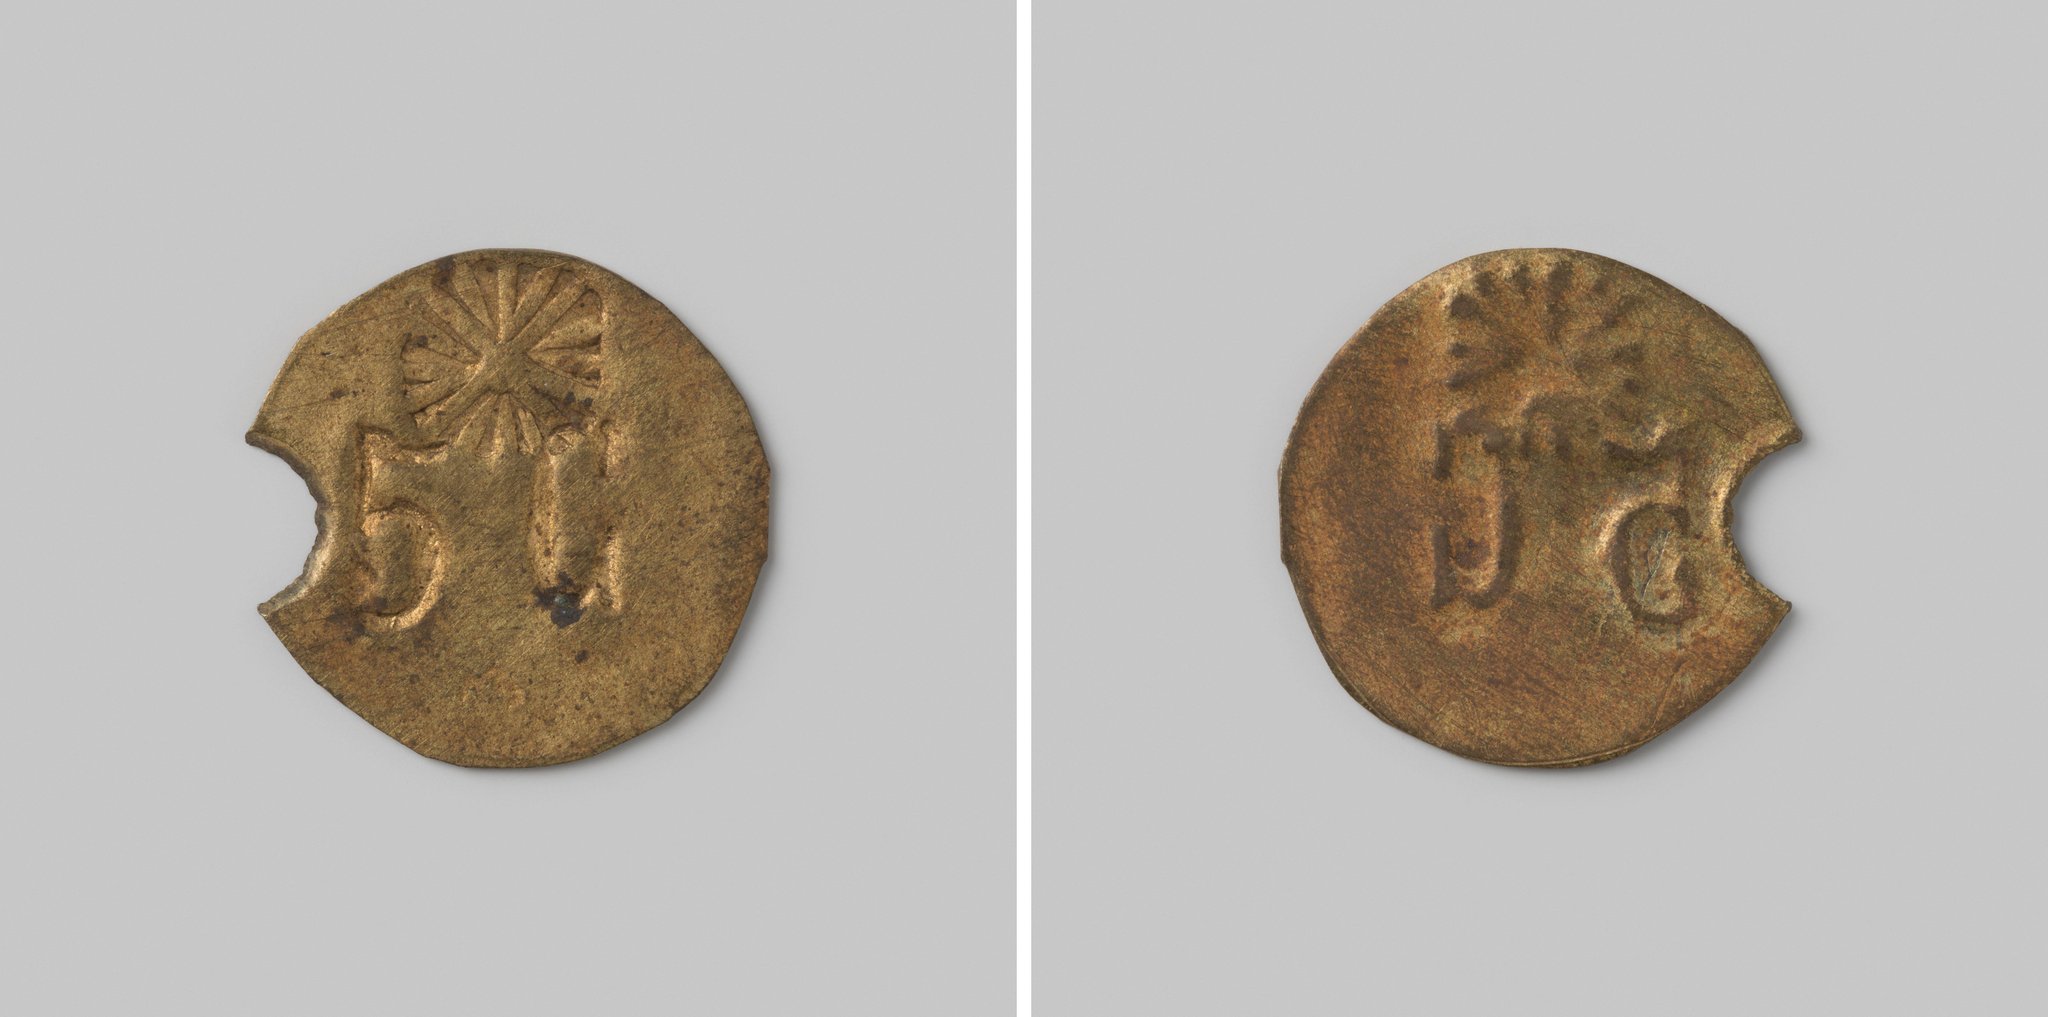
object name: history medal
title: Betaalpenning van 5 cents van de Coöperatieve Winkelvereeniging Eendracht Maakt Magt te Hilversum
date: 1875-1900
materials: brass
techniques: printing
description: Rond messing plaatje met randuitsparing met inwaartse instempelingen (ster) / 5 C